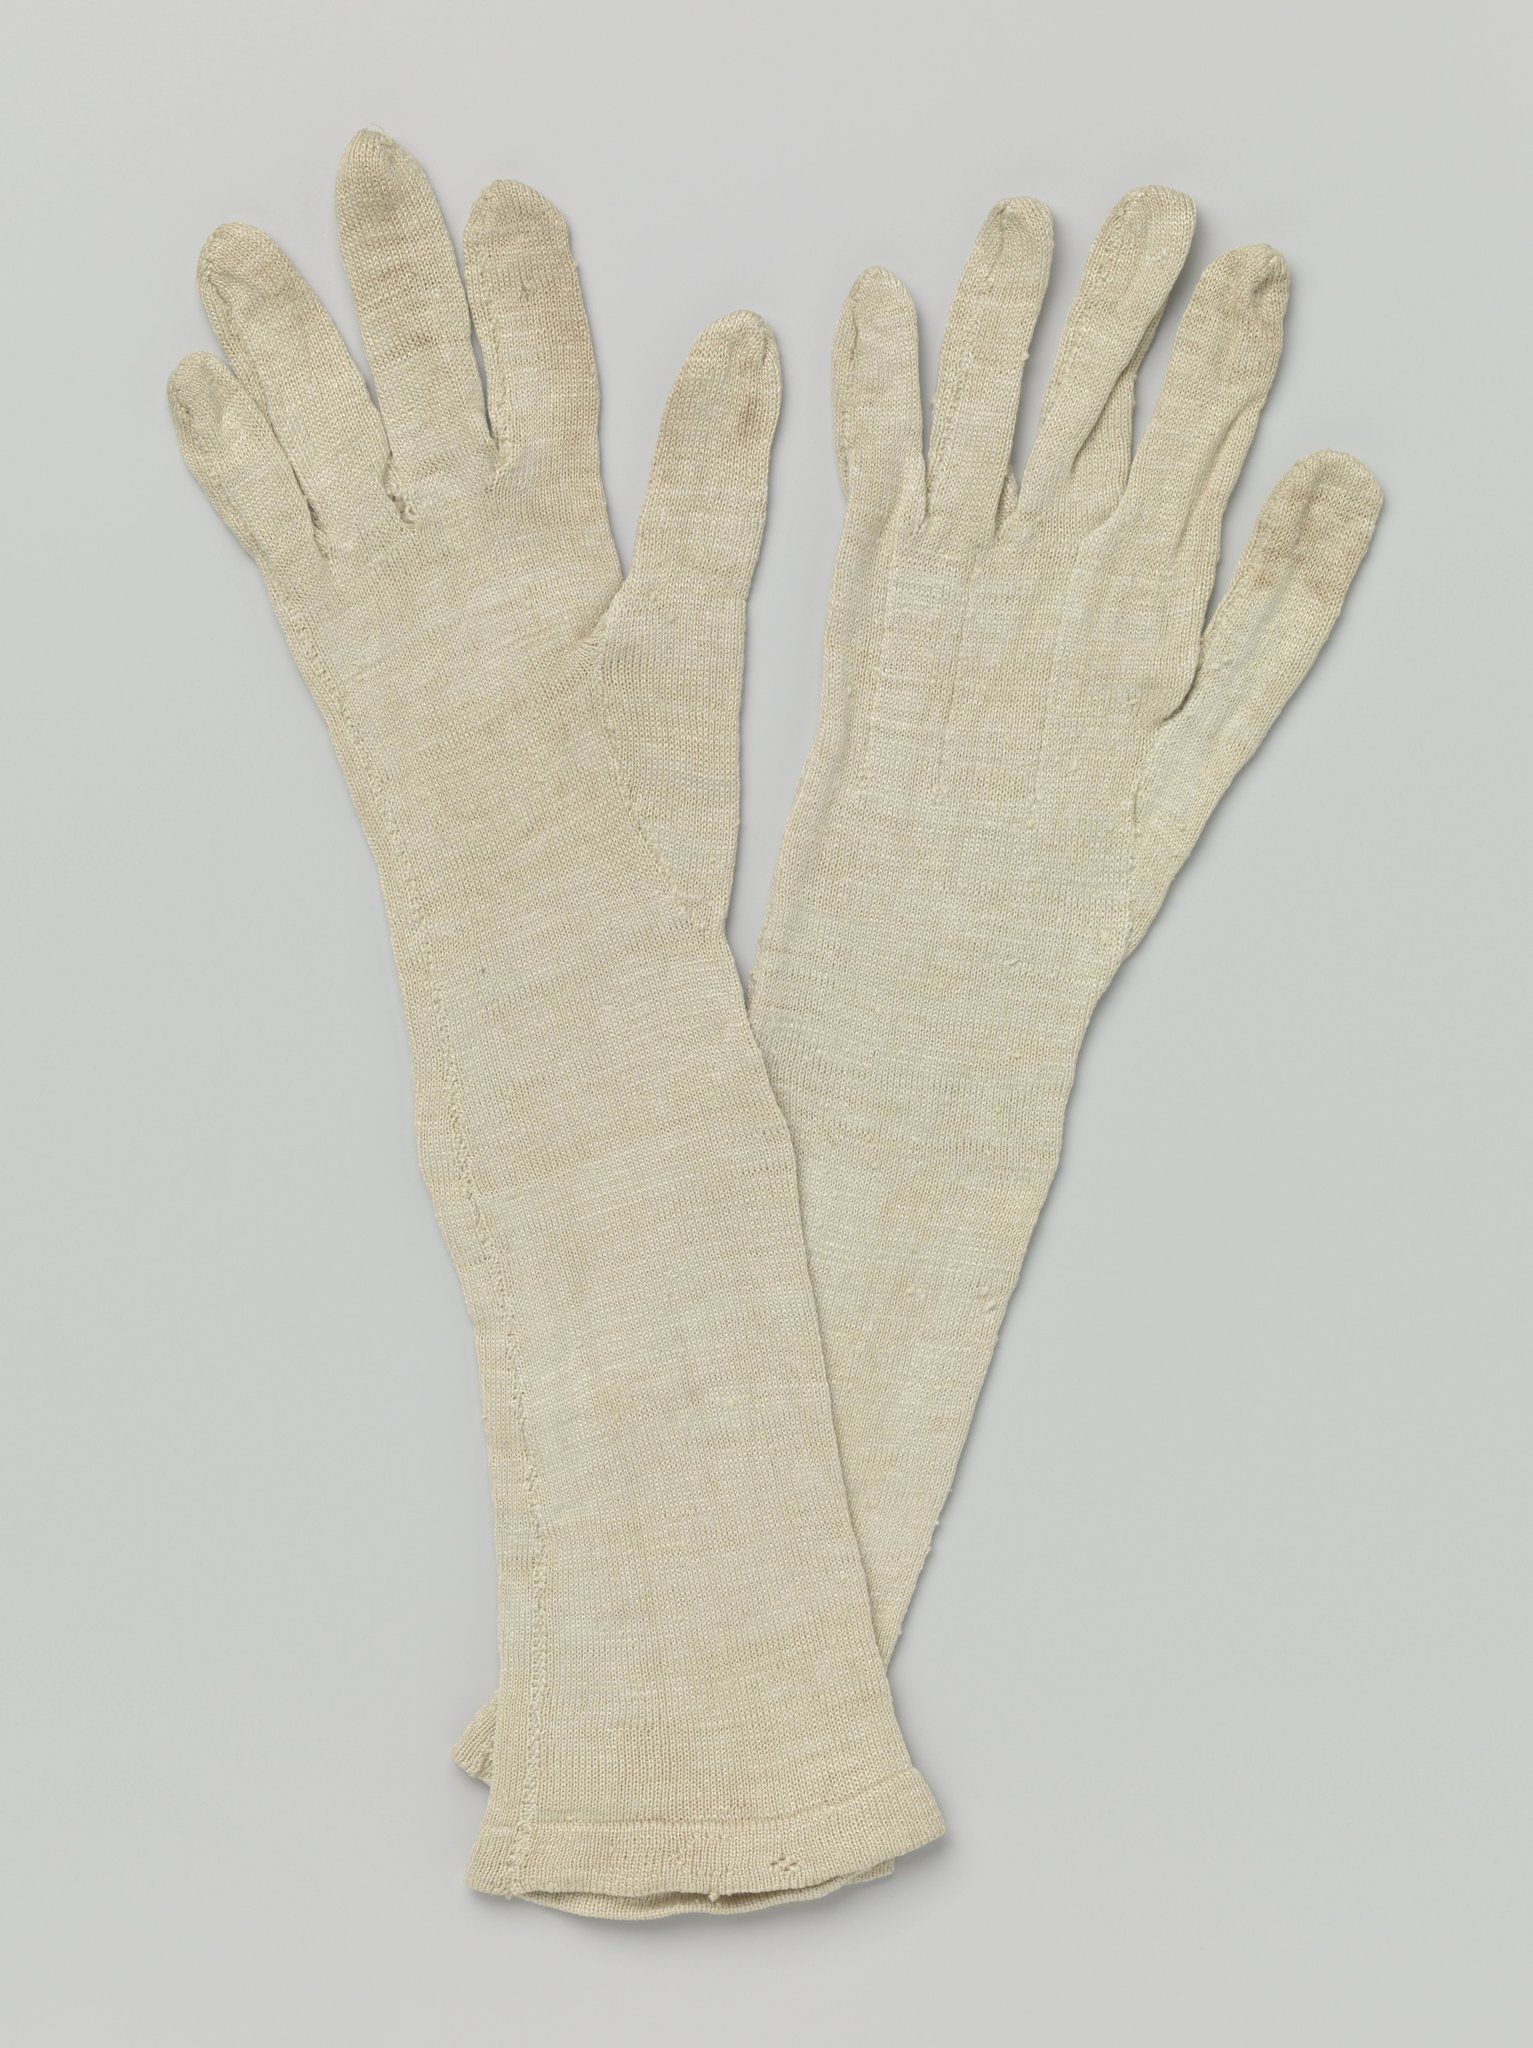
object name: glove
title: Handschoen van grijsblauwe gebreide zijde en wol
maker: Anonymous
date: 1800-1850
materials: silk, wool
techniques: knitting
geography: western europe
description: Rechter handschoen van grove lichtgrijze gebreide zijde en wol. Van binnen geruwd.